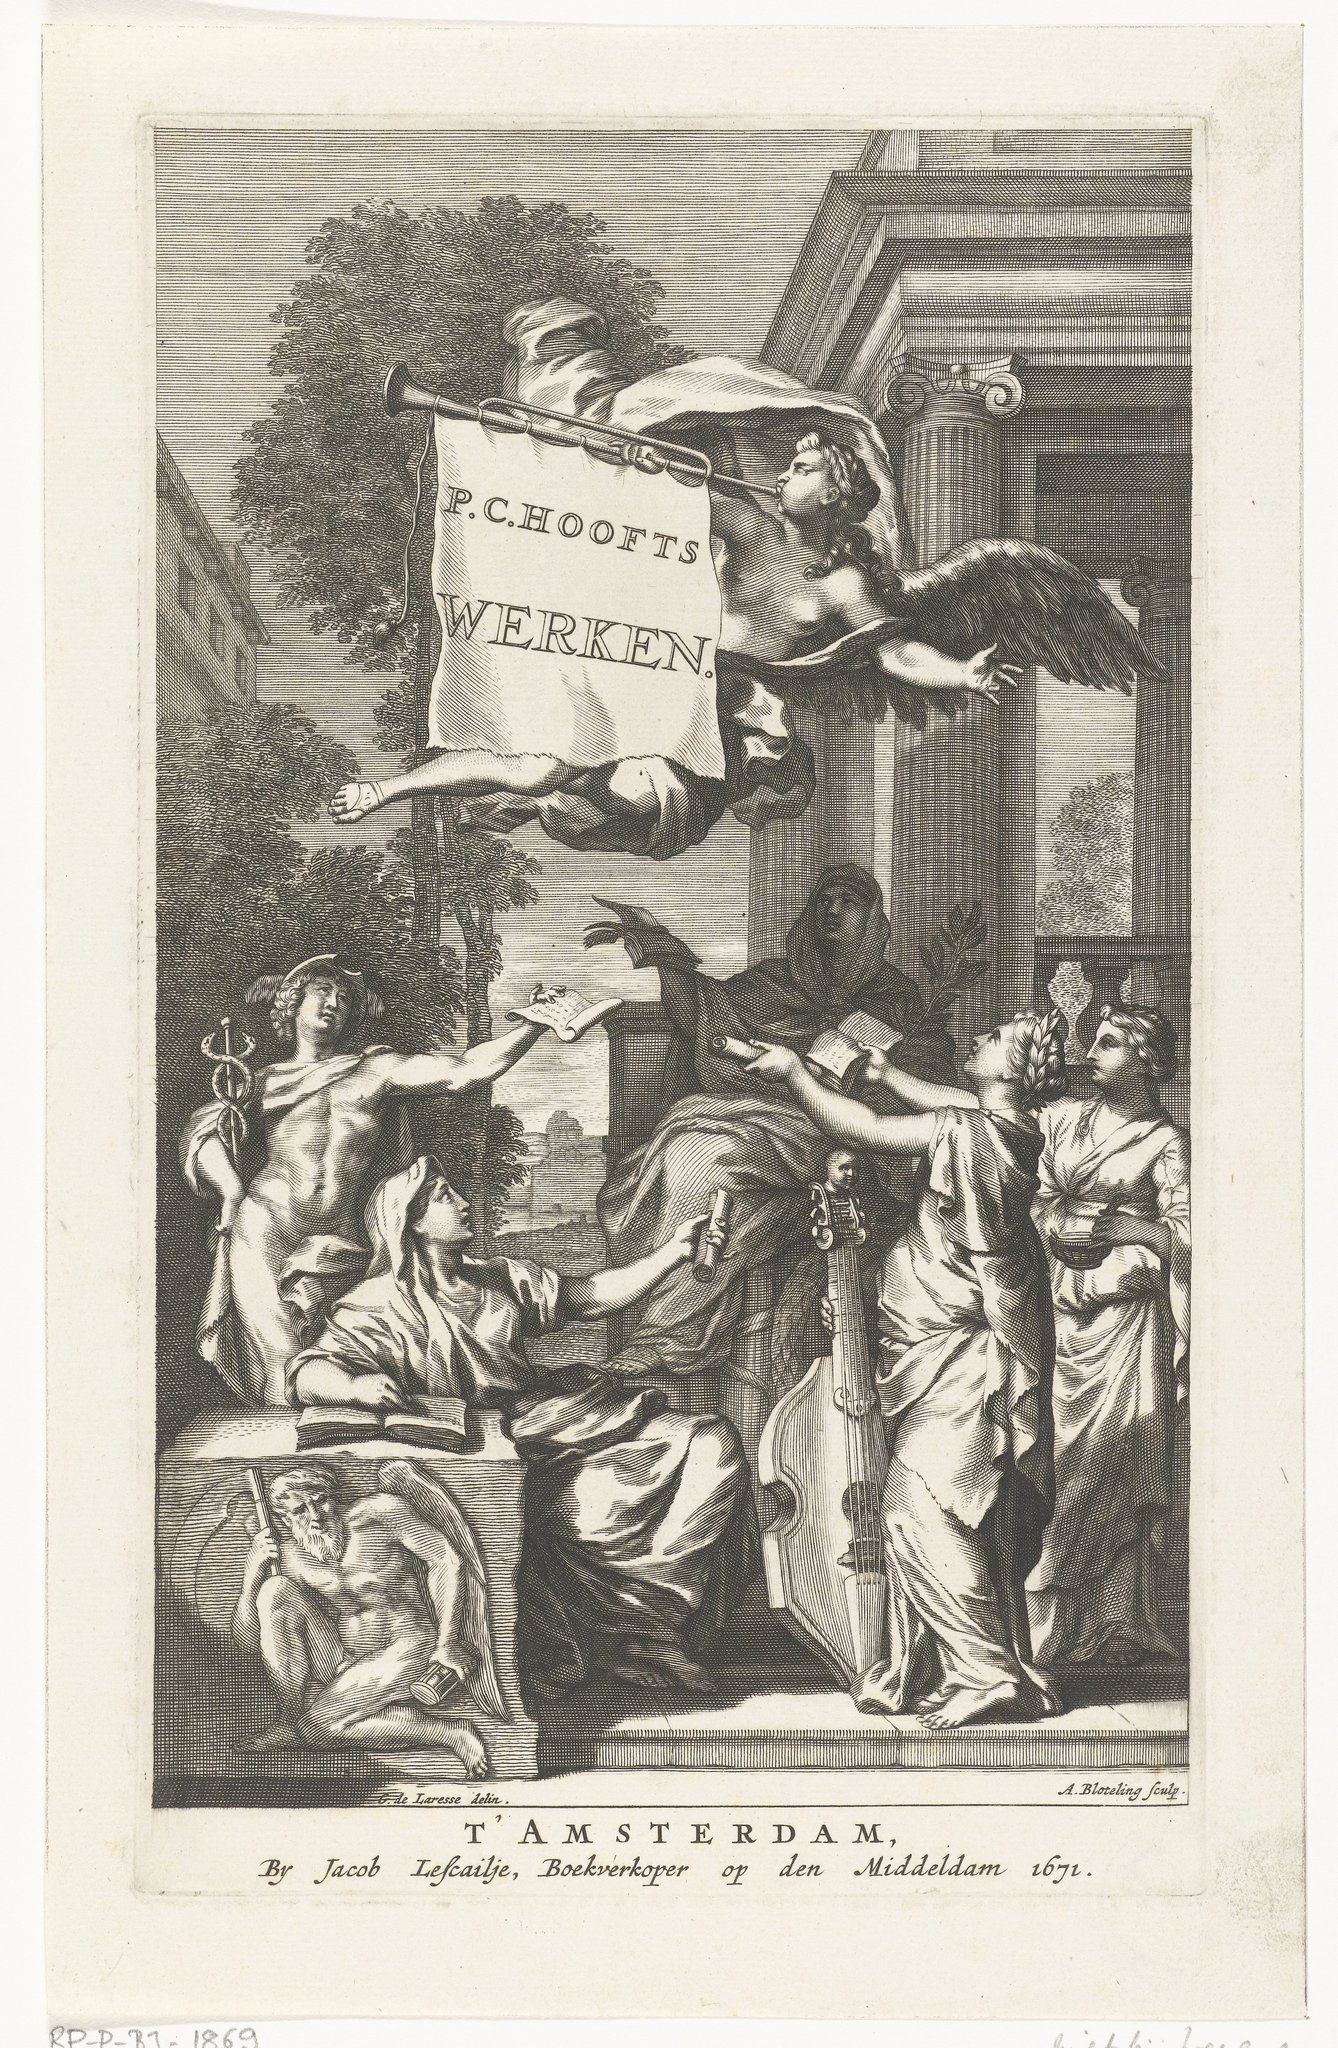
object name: print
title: Titelpagina voor: P.C. Hooft, Werken, Amsterdam, 1671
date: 1671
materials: paper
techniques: engraving, etching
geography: amsterdam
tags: (story of) mercury (hermes), fame; 'fama', 'fama buona', 'fama chiara' (ripa) (+ personification), viola, violoncello; double bass, father time, man with wings and scythe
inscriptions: collector's mark: Lugt 240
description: Een engel blaast op een bazuin met een doek waarop de titel van het boek staat. Een aantal figuren tonen geschriften aan de engel. Links staat Mercurius, rechts voor een vrouw met een viola da gamba, achter haar zit een vrouw op een troon.